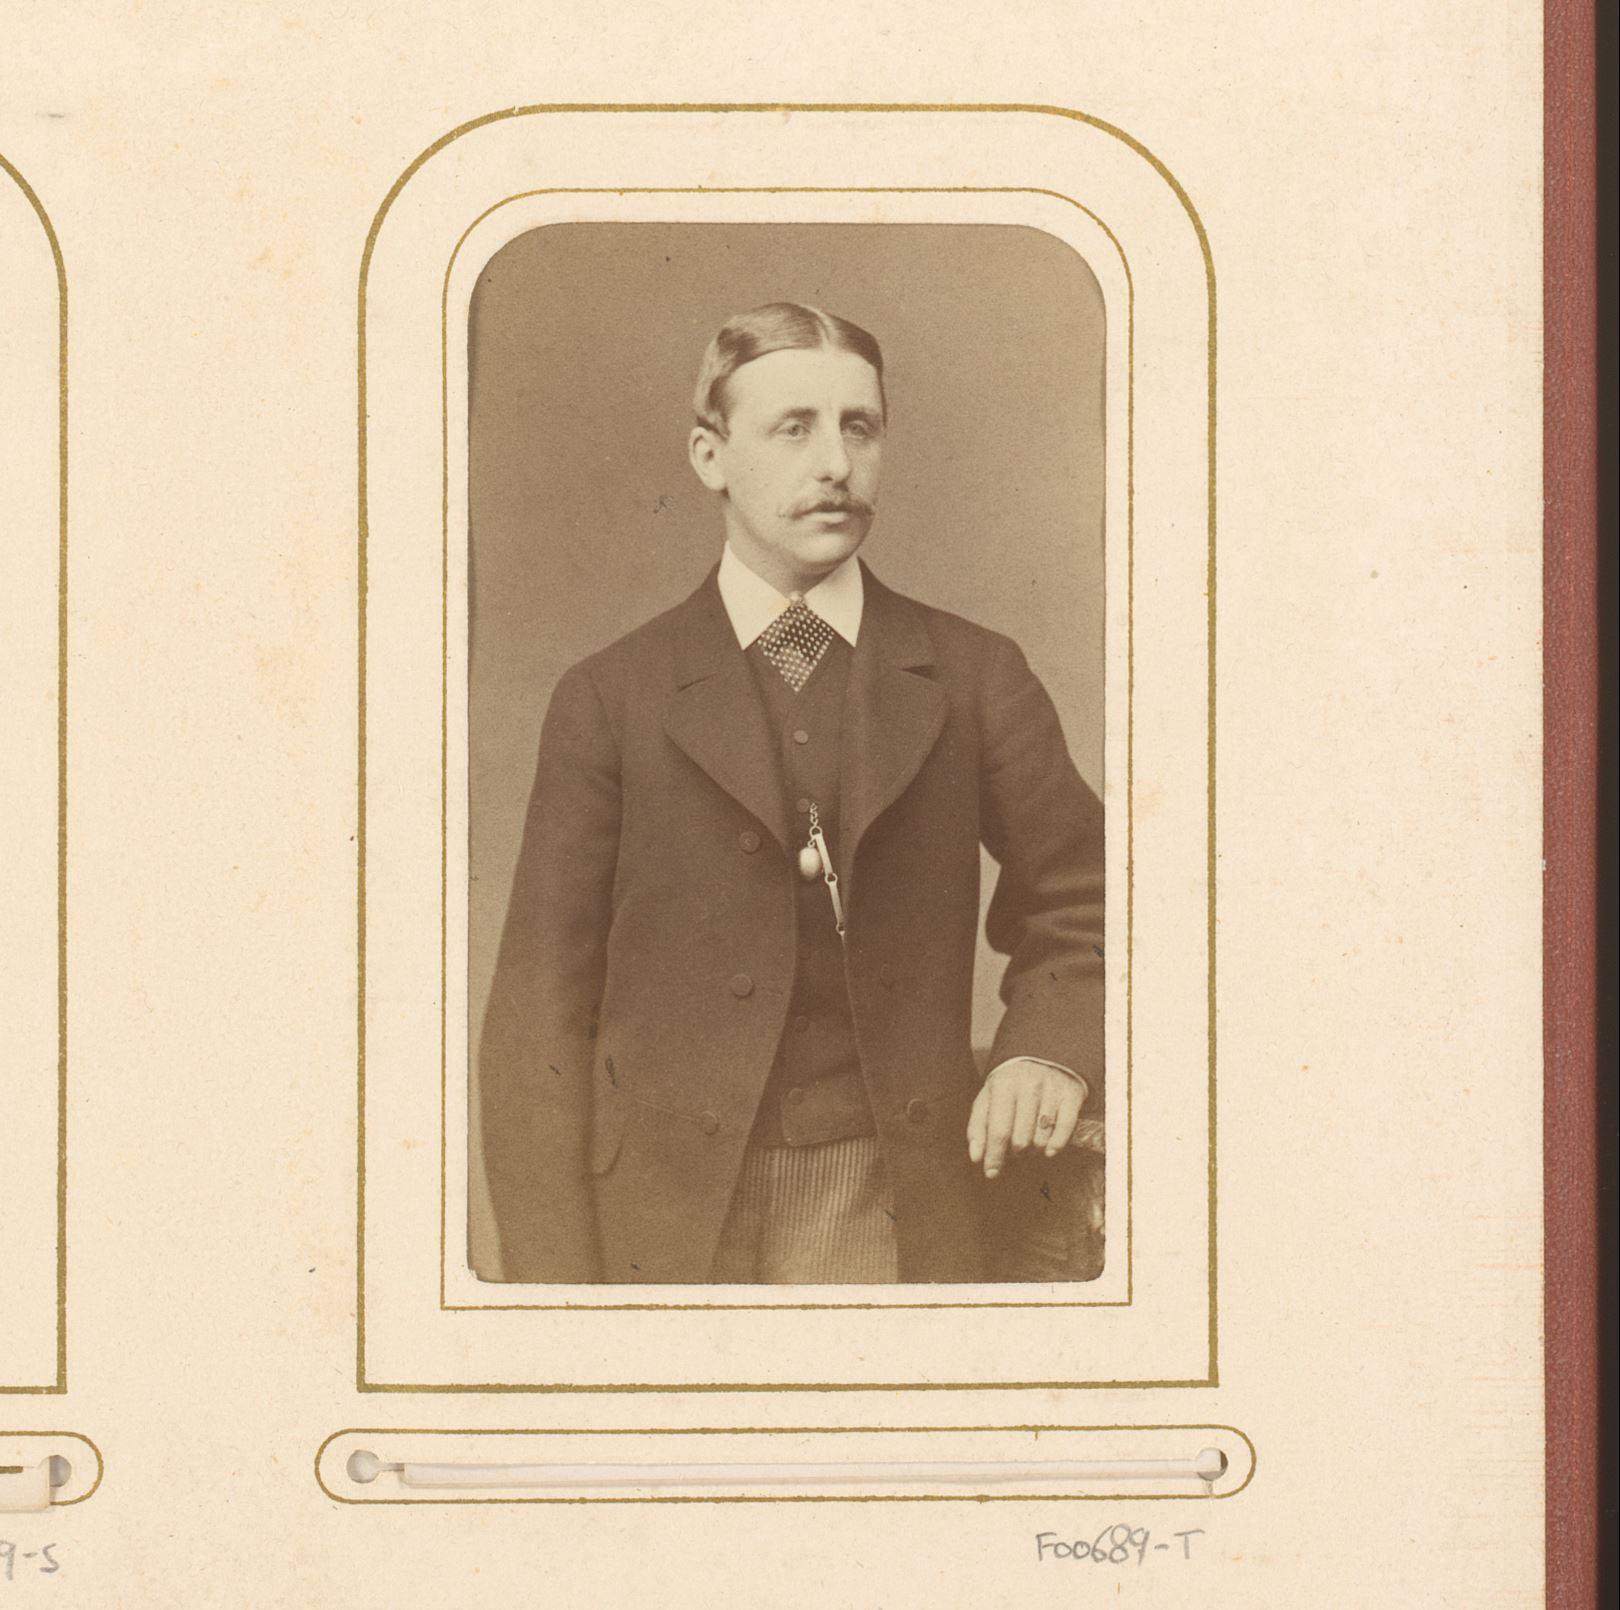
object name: photograph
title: Portret van een man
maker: robert jefferson bingham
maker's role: printer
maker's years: 1824-1870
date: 1867-1870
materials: cardboard, photographic support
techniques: albumen print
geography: paris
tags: historical persons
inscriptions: inscription: ‘Bingham/ Médaille de 1rs classe/ 1855-1862-1867/ Inventeur du procédé collodion/ Rue de Larochefoucauld, 58/ Paris’